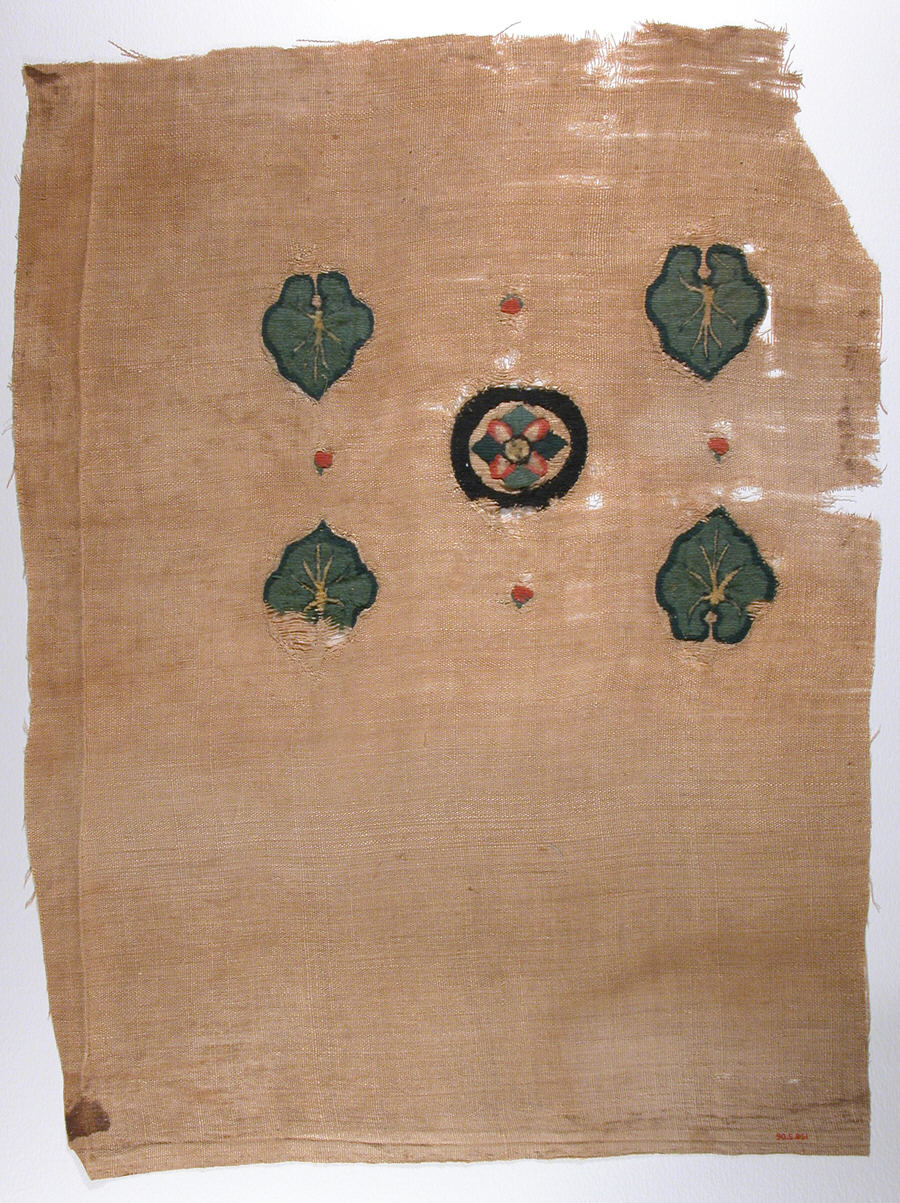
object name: textile fragment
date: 101-300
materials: linen, wool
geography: egypt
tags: leaves